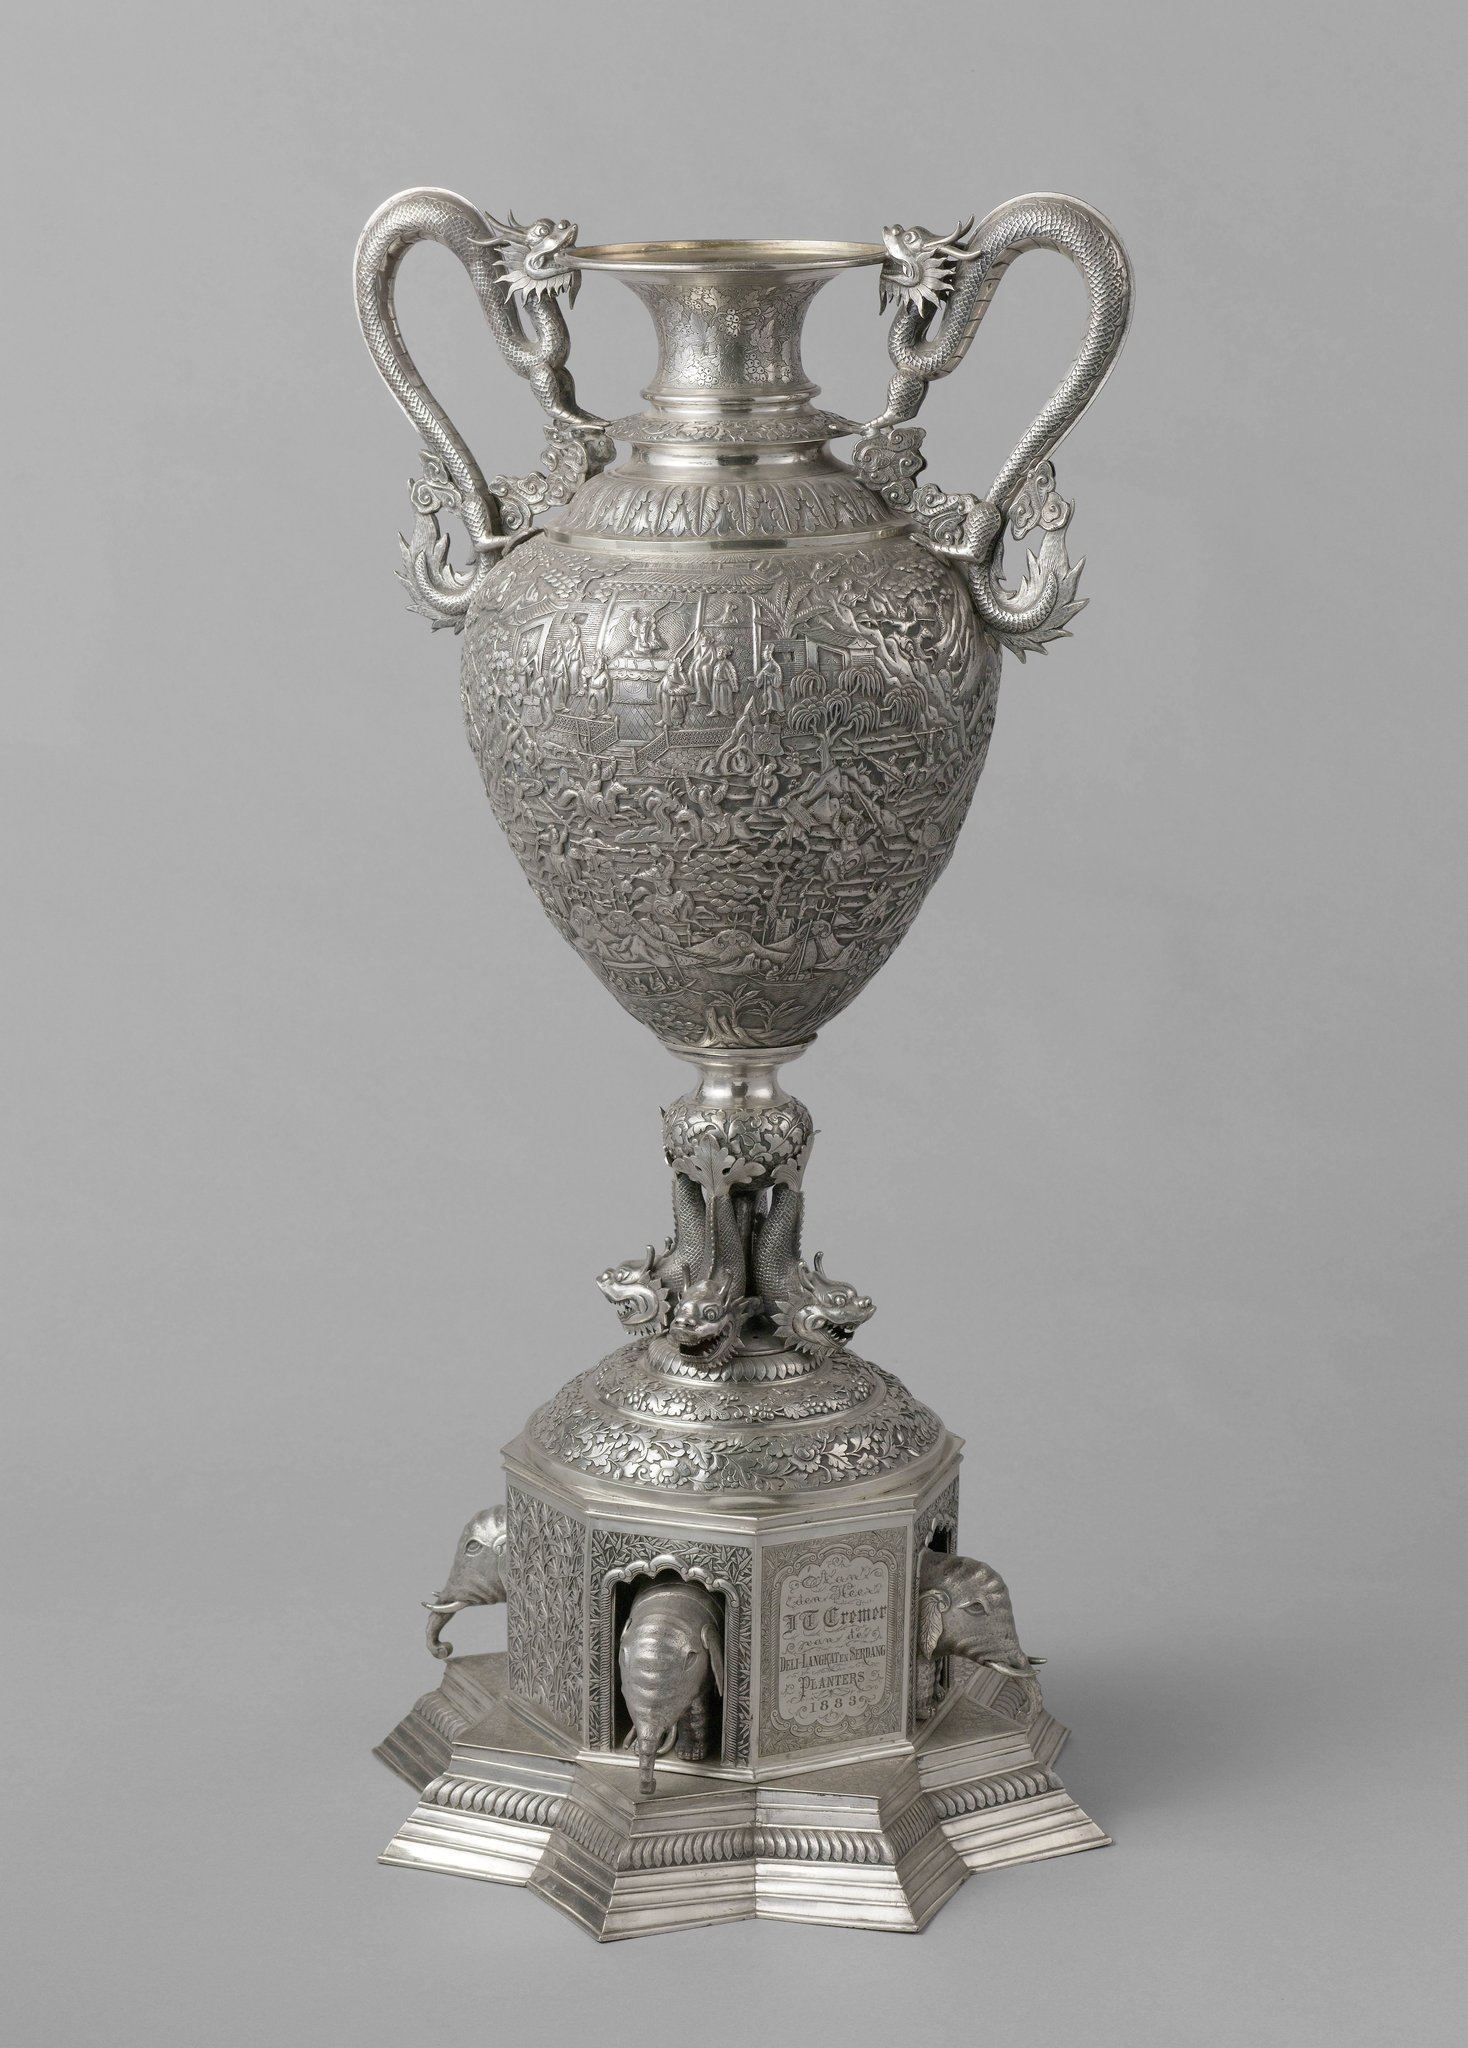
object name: table piece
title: Silver table centrepiece with Chinese scenes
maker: Anonymous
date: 1880-1883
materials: silver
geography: china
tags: amsterdam, sumatra, china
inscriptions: mark, inscription: ‘Aan den Heer J.T. Cremer van de Deli-Langkat en Serdang planters 1883’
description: Rijk versierde zilveren tafelstuk in 1883 aangeboden aan de heer J.Th. Cremer. Stervormig voetstuk met 8 punten waarop een 8-hoekig deel met 4 uitkomende olifanten en opschrift. Tussen vaas en voetstuk 4 dragende vissen. Op de vaas voorstellingen uit het Chinese leven. Twee handvatten in de vorm van draken. Bovenop los deksel bekroond met een Chinese mandarijn.